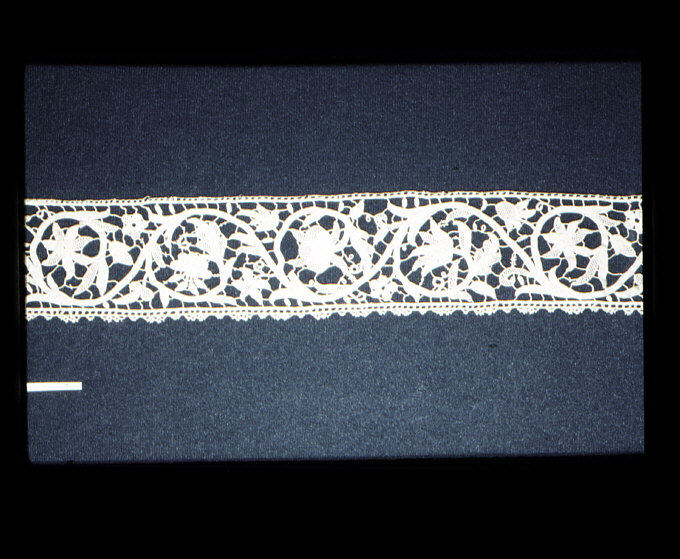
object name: strip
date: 1601-1700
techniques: lace